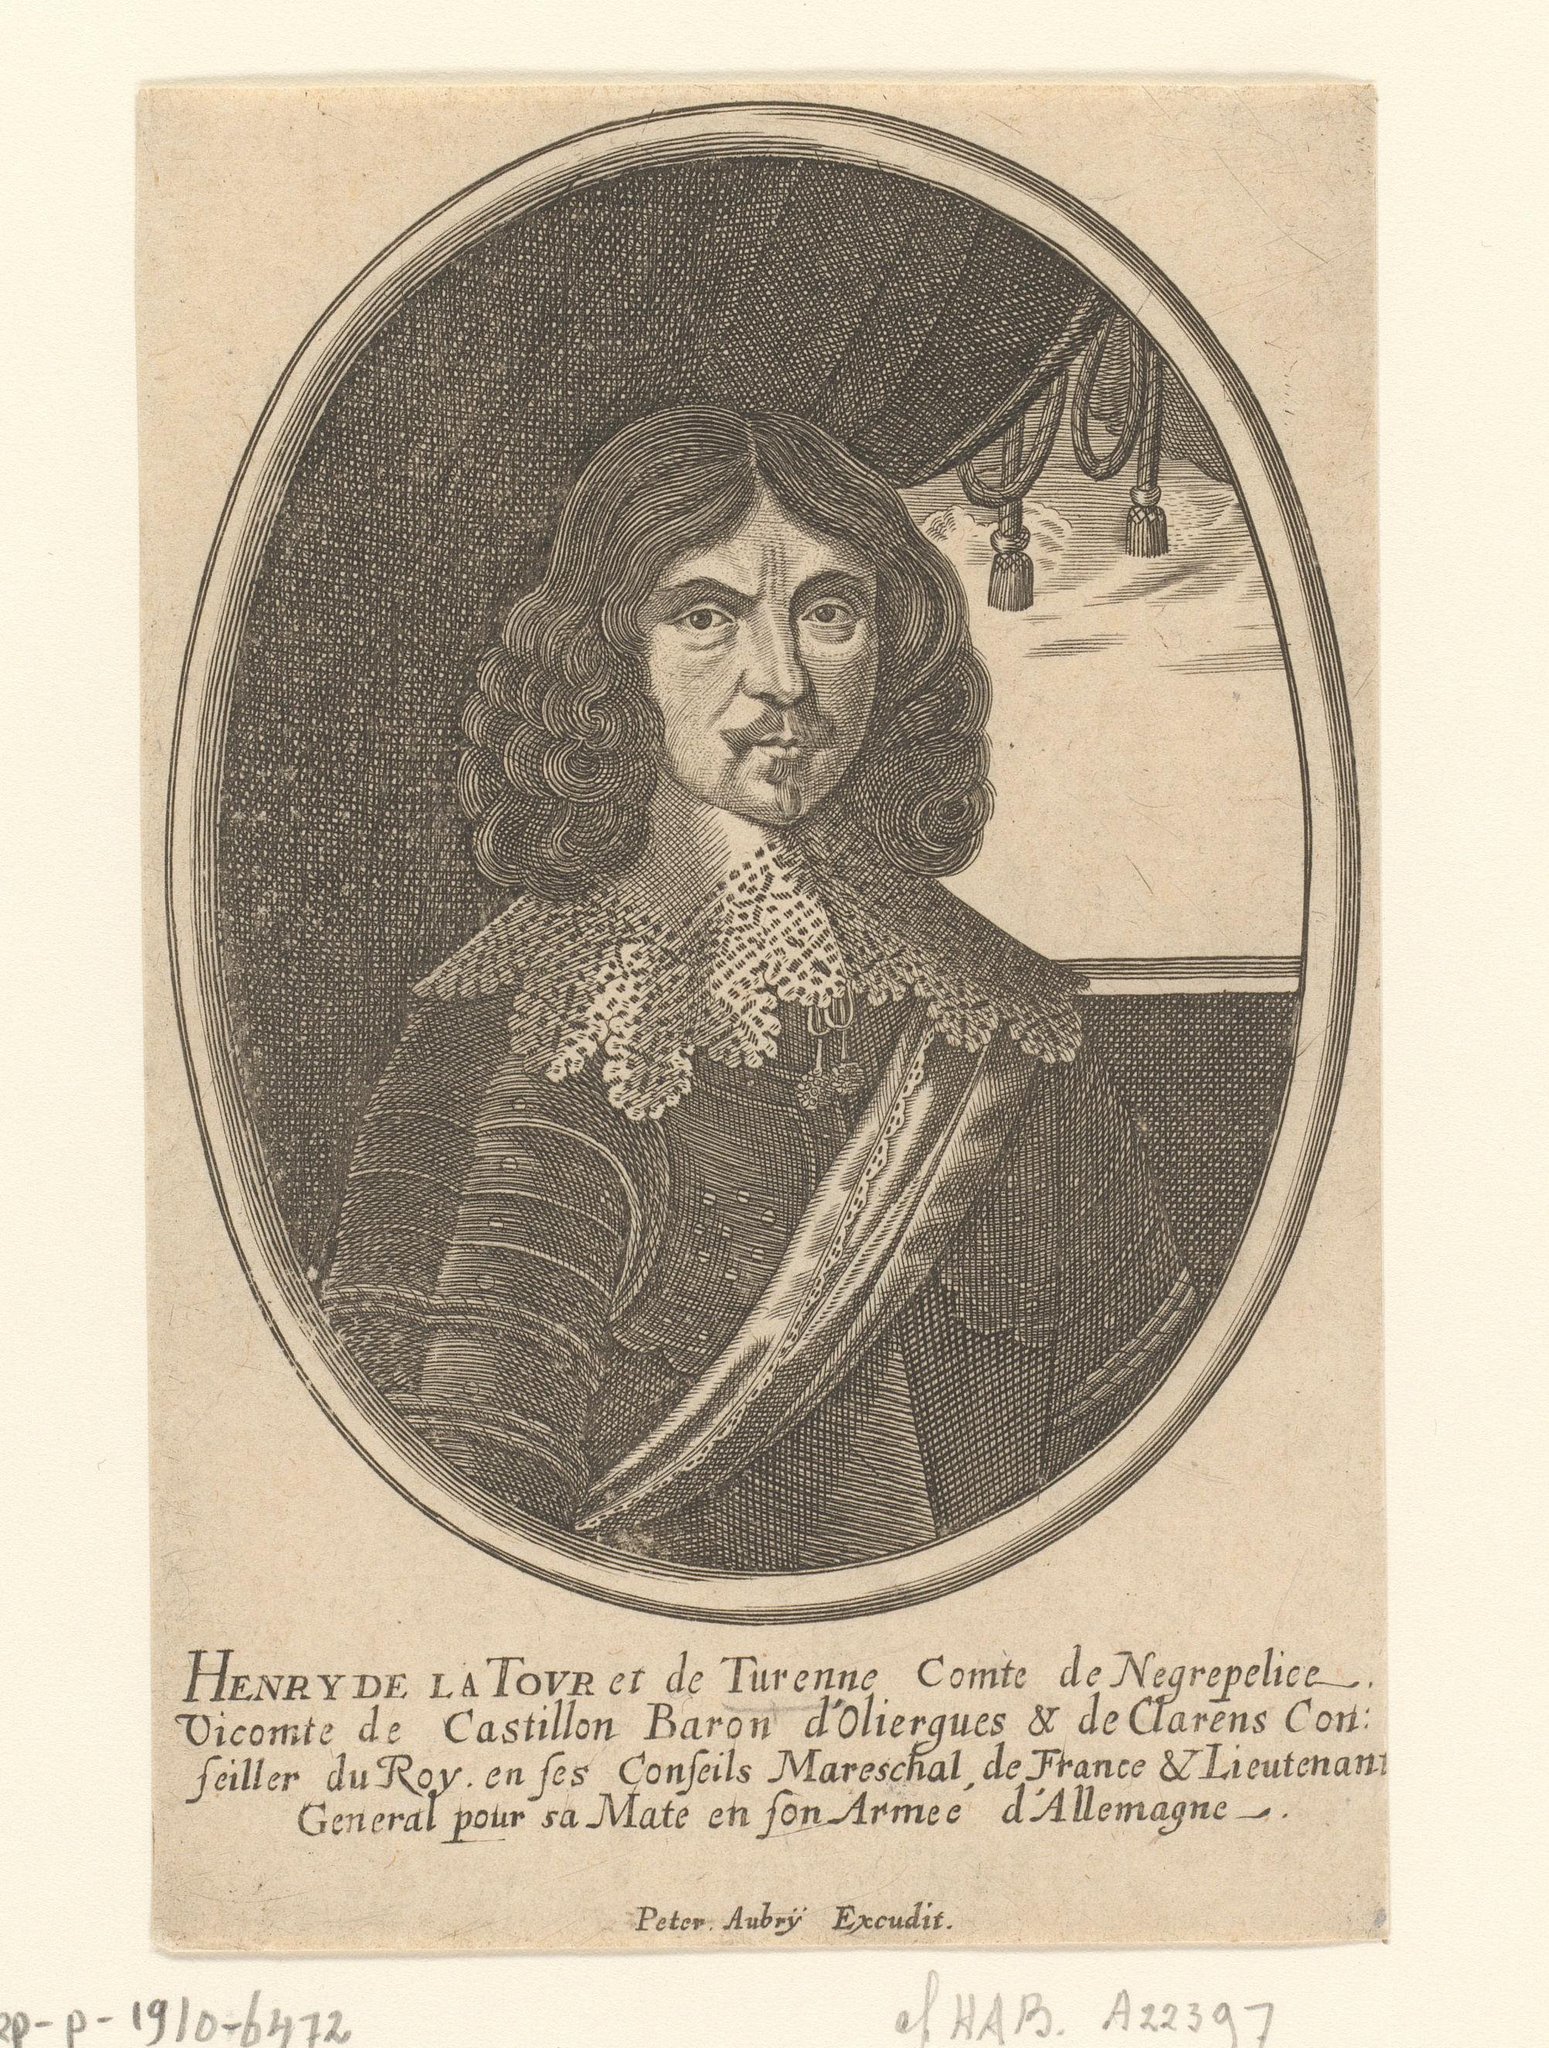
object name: print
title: Portret van Henri de La Tour d'Auvergne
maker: Anonymous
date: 1643-1686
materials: paper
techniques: engraving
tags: commander-in-chief, general, marshal, historical persons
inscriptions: collector's mark: Lugt 2228